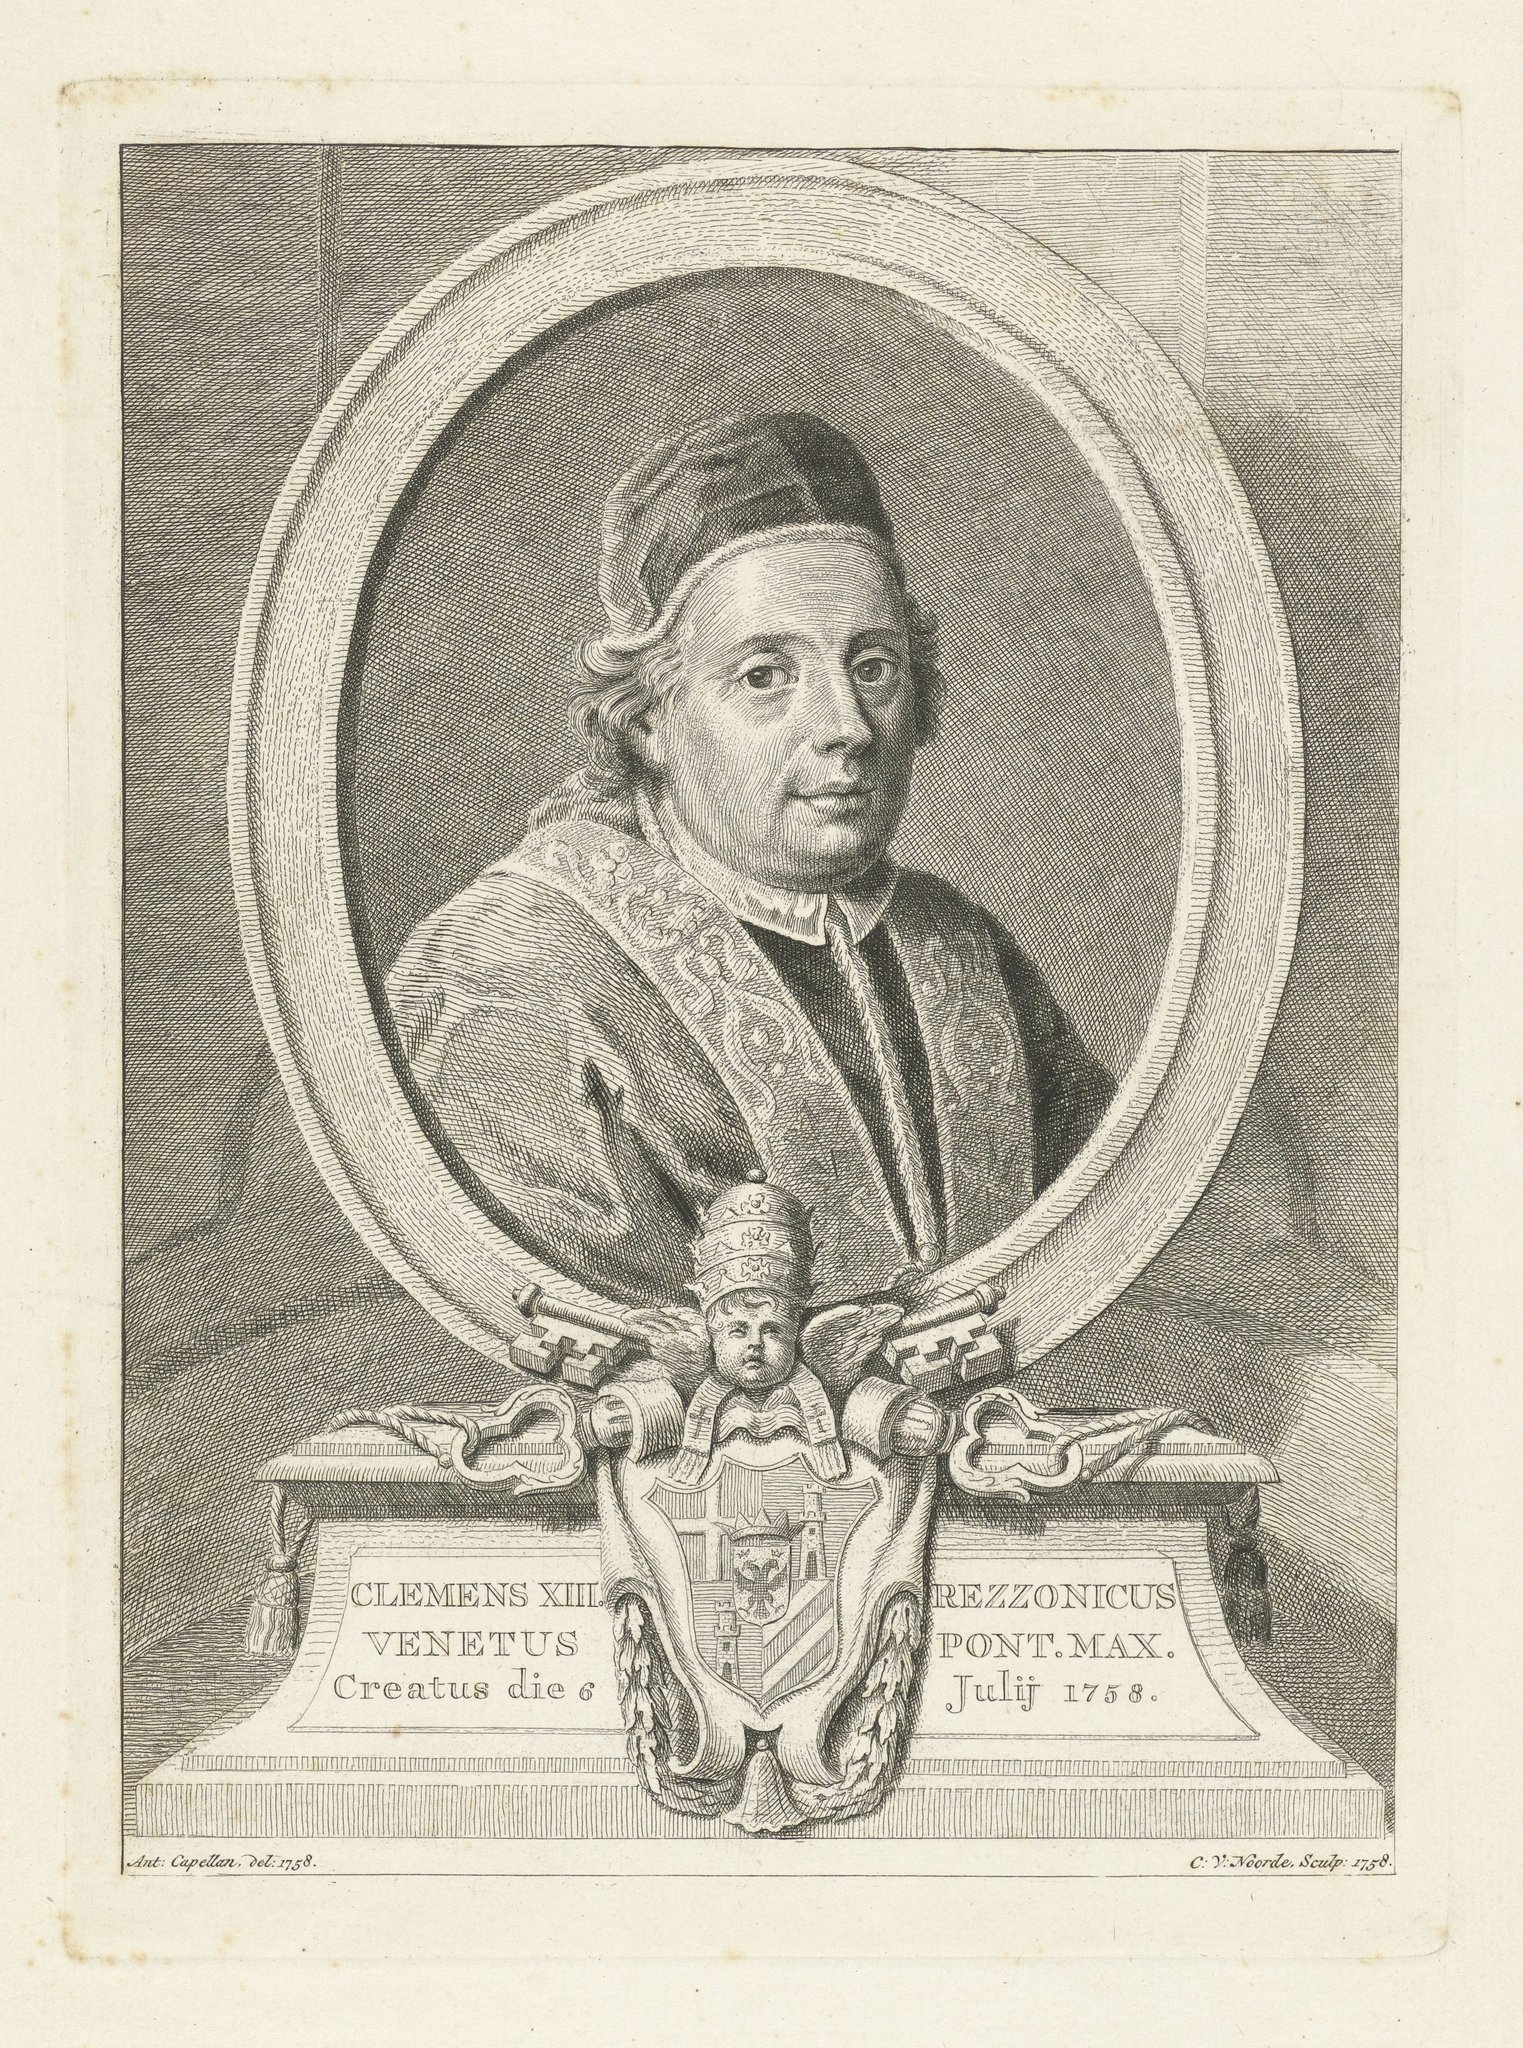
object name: print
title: Portret van paus Clemens XIII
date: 1758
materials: paper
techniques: engraving, etching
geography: haarlem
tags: clemens xiii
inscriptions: collector's mark: Lugt 240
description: Portret van paus Clemens XIII met zijn pauselijk wapen onder het portret. Hij werd paus op 6 juli 1758.